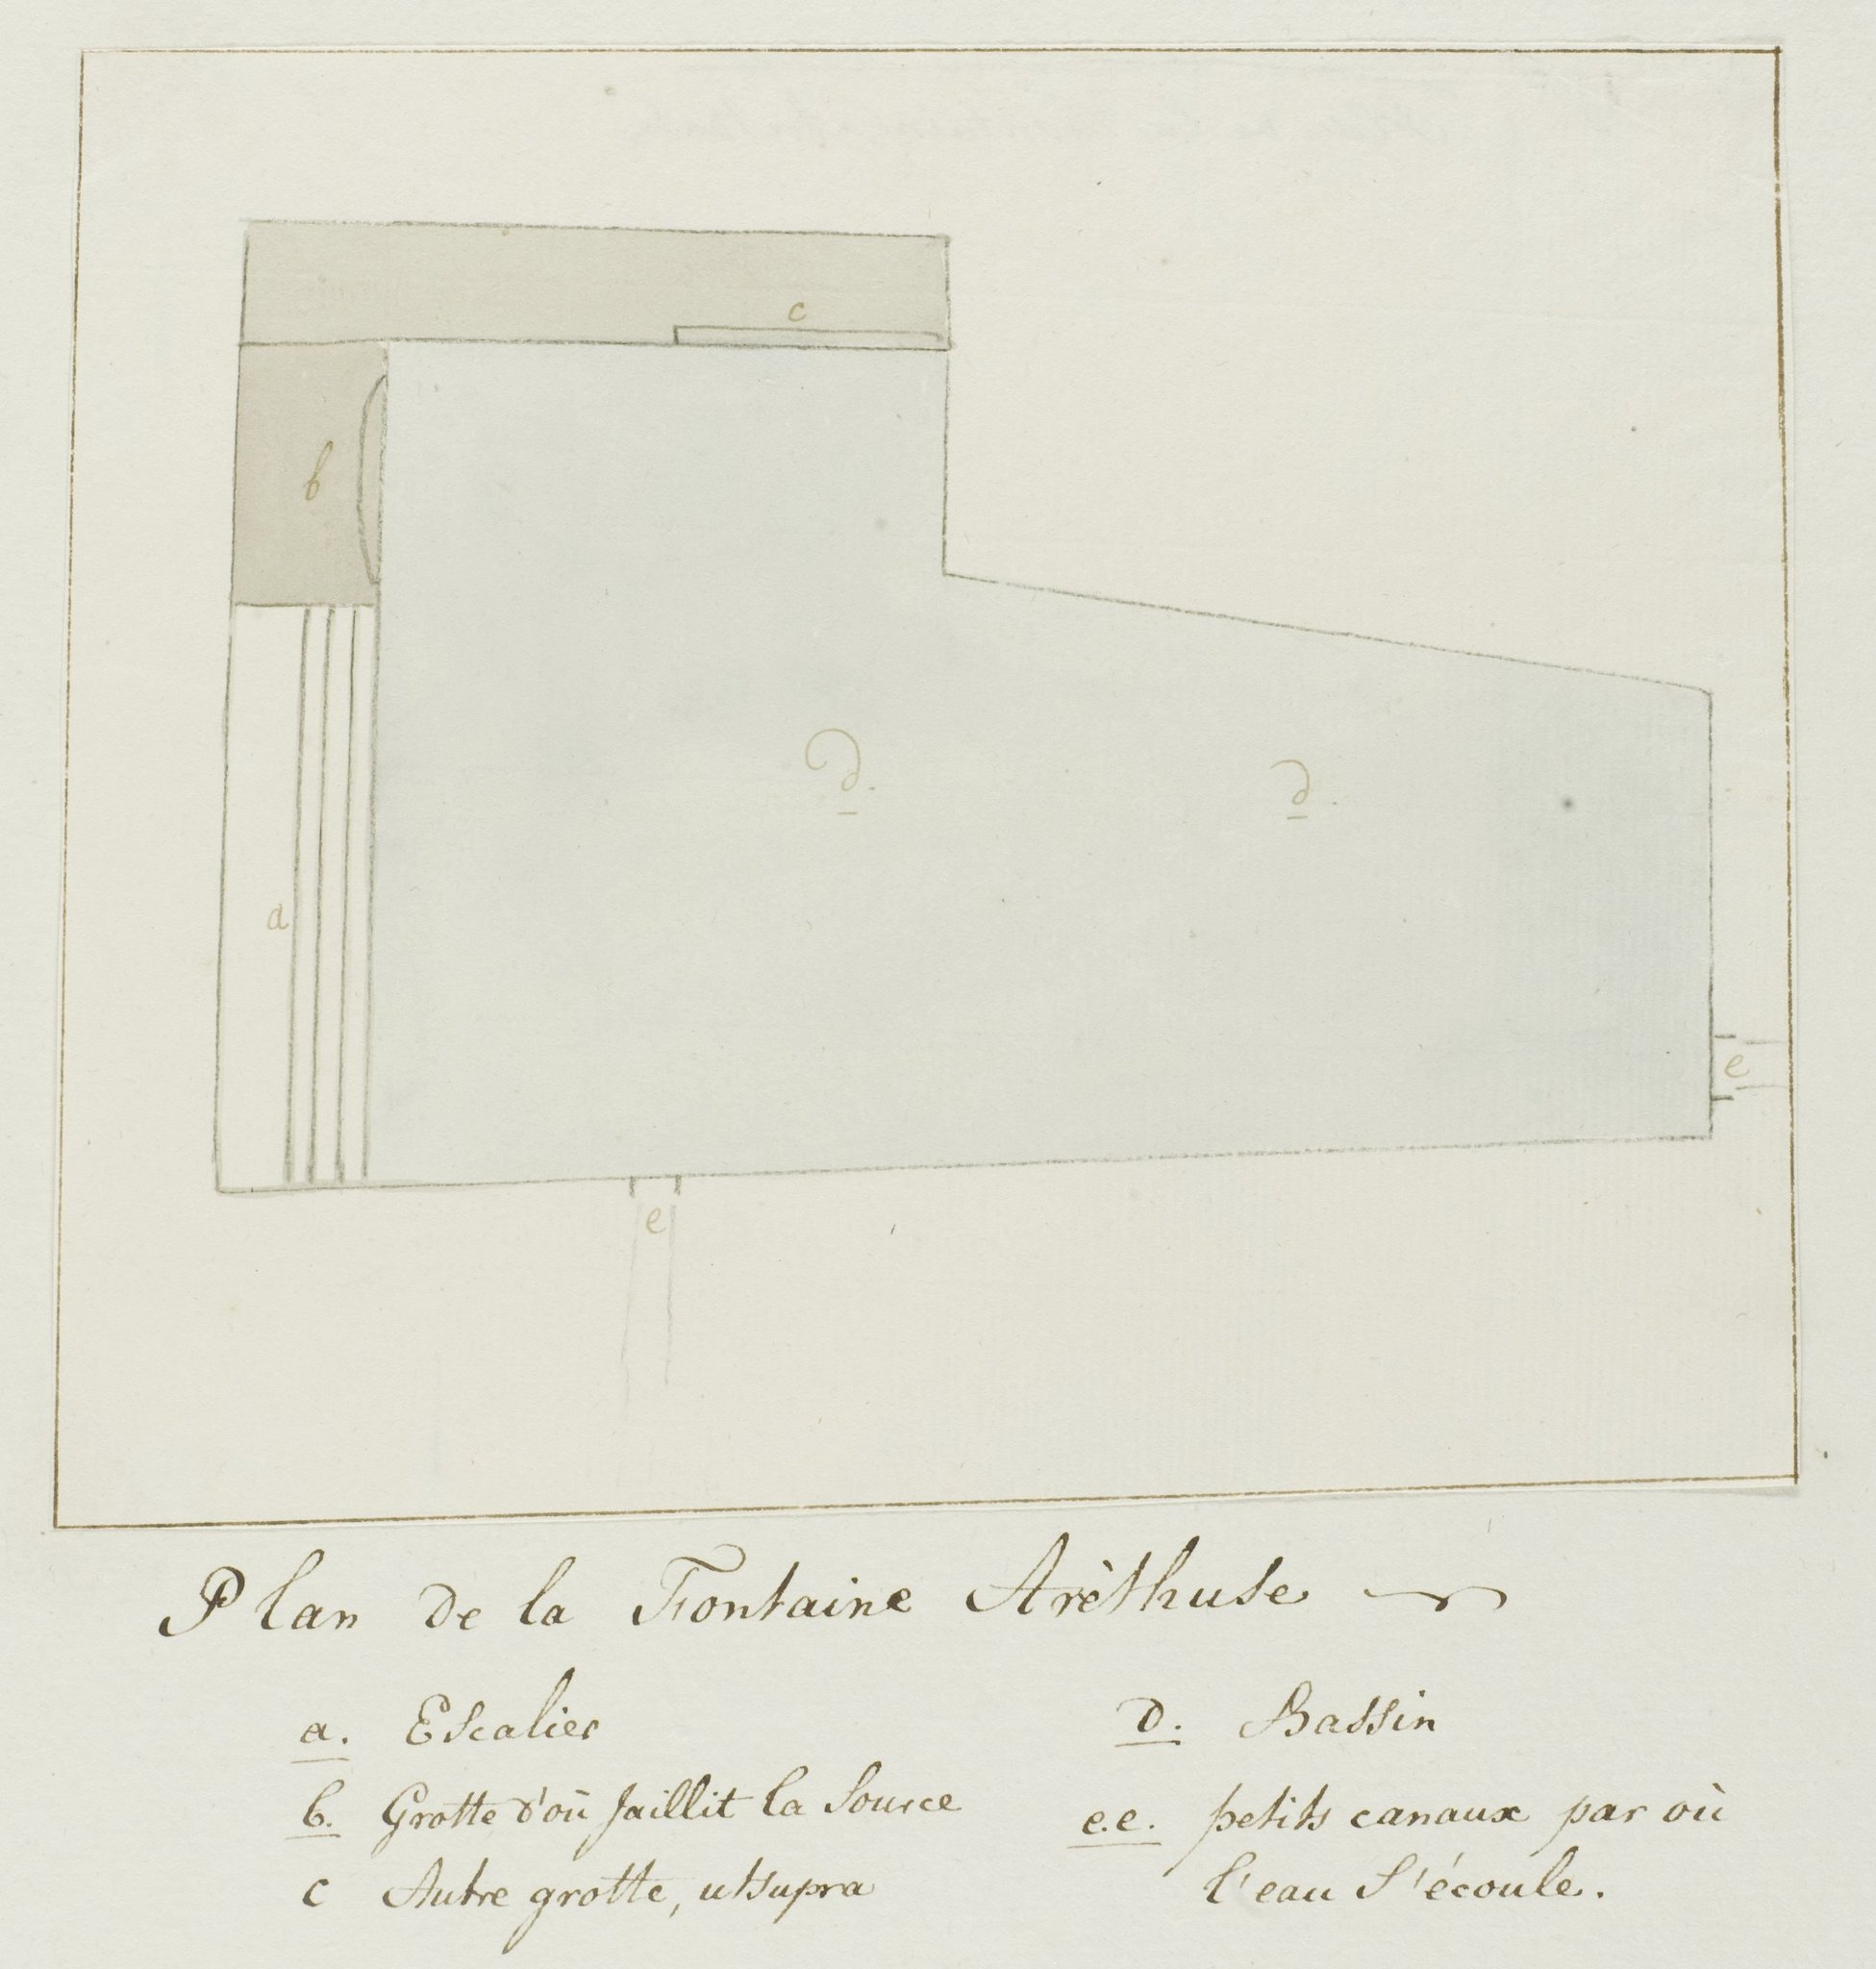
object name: watercolor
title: Plan de la Fontaine Aréthuse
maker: louis ducros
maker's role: draughtsman, print maker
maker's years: 1748-1810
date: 1778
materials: chalk, paper, watercolor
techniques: brush, pen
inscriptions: inscription: ‘No 196 Plan de la Fontaine Aréthuse’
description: Tekening uit het album 'Voyage en Italie, en Sicile et à Malte', 1778.